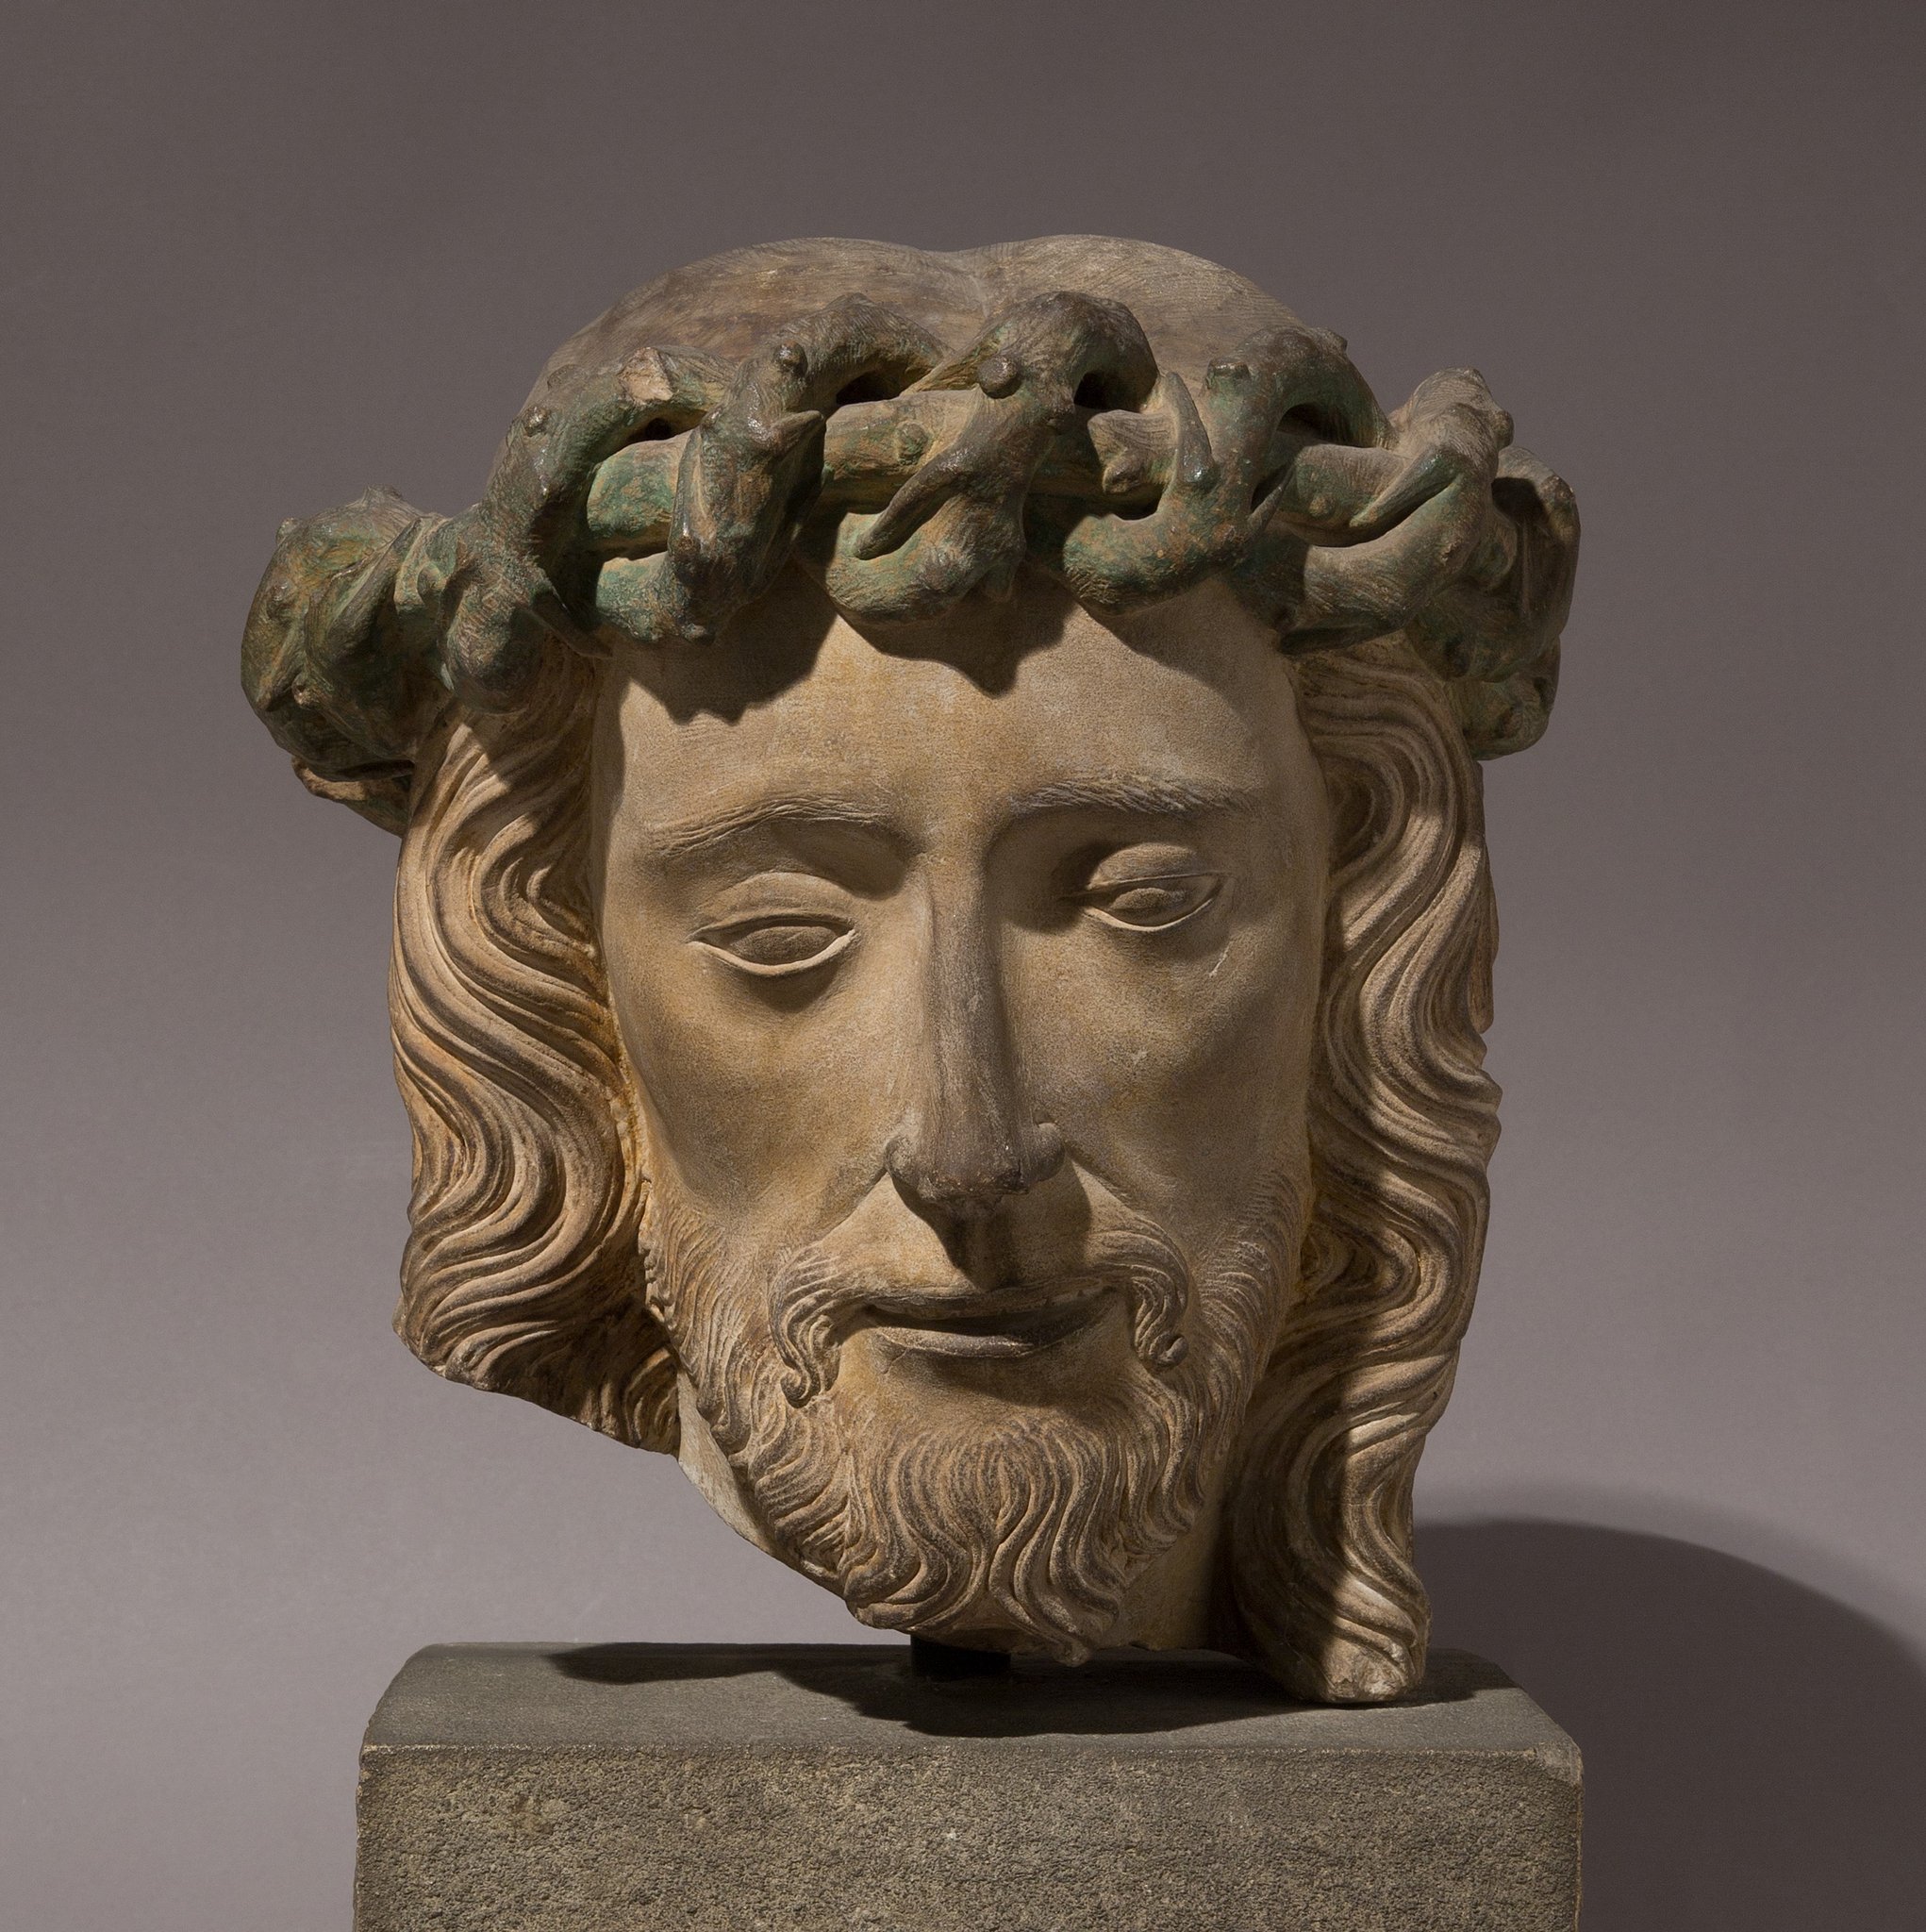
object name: statue head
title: Head of Christ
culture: french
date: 1401-1500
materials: limestone, paint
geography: france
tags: heads,christ